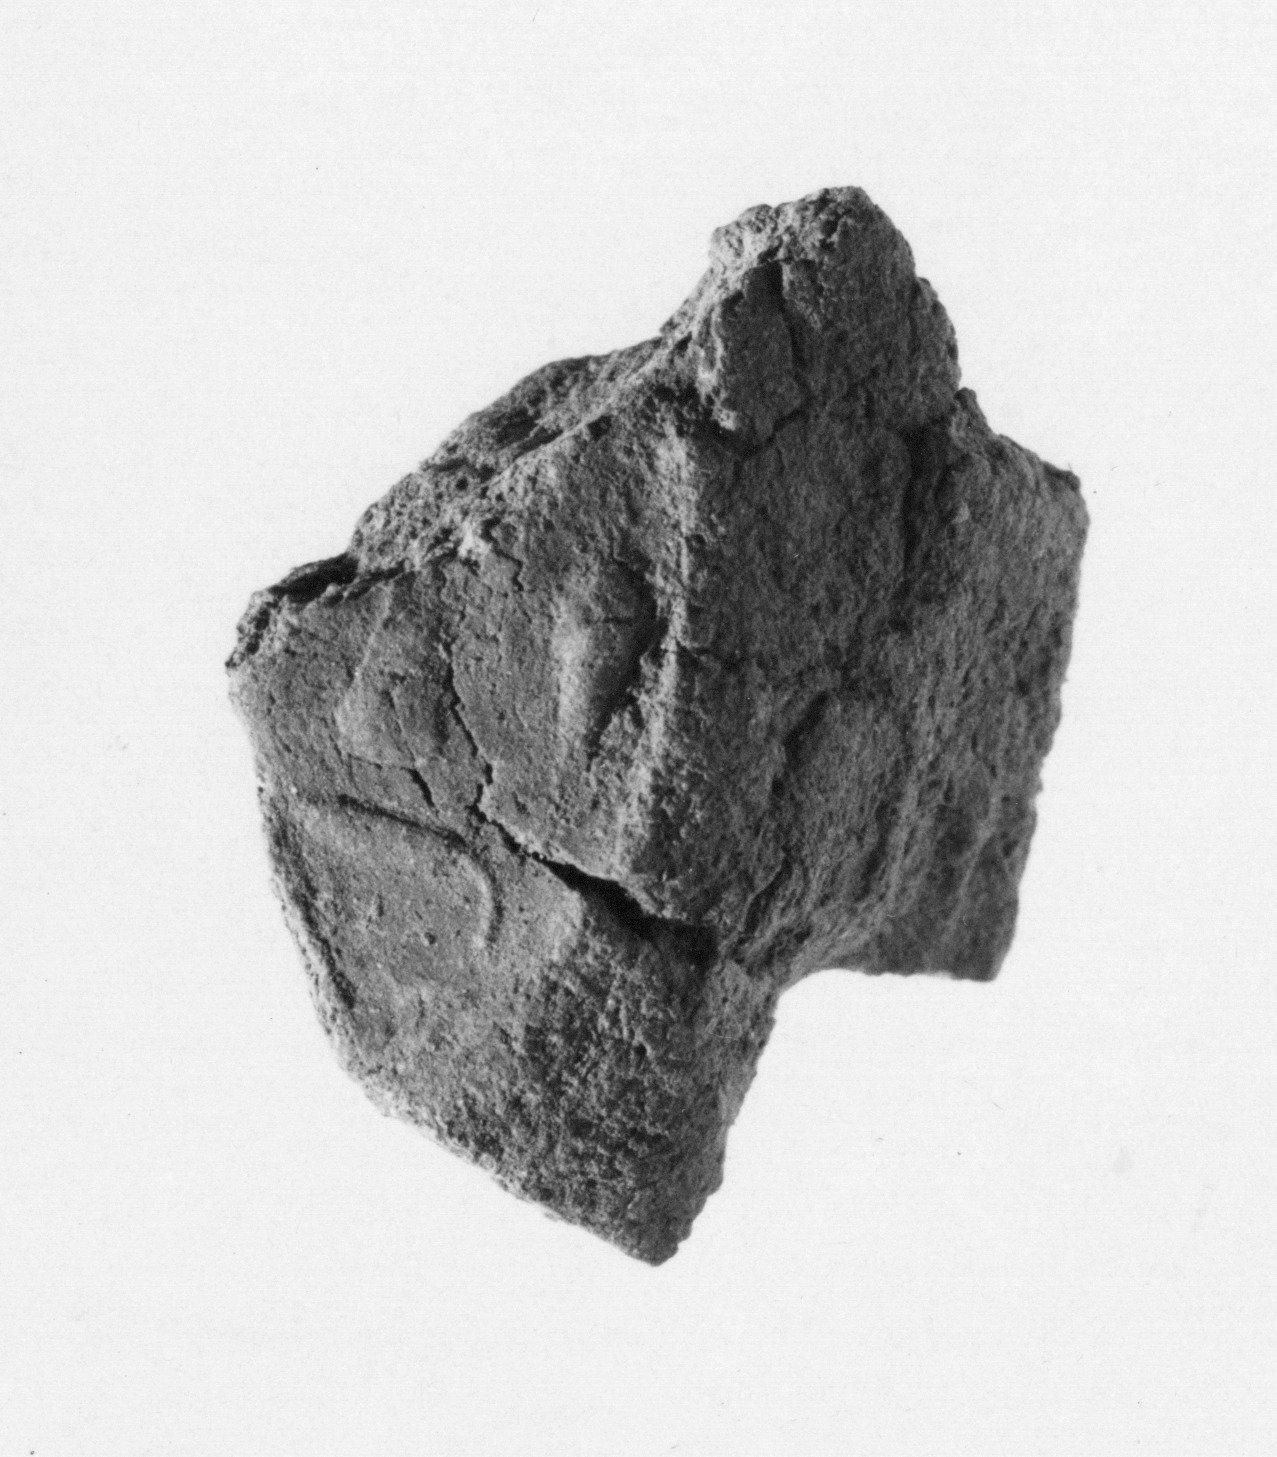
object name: sealing, djed, cobra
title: Document Sealing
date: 1390-1352 BCE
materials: mud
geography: egypt